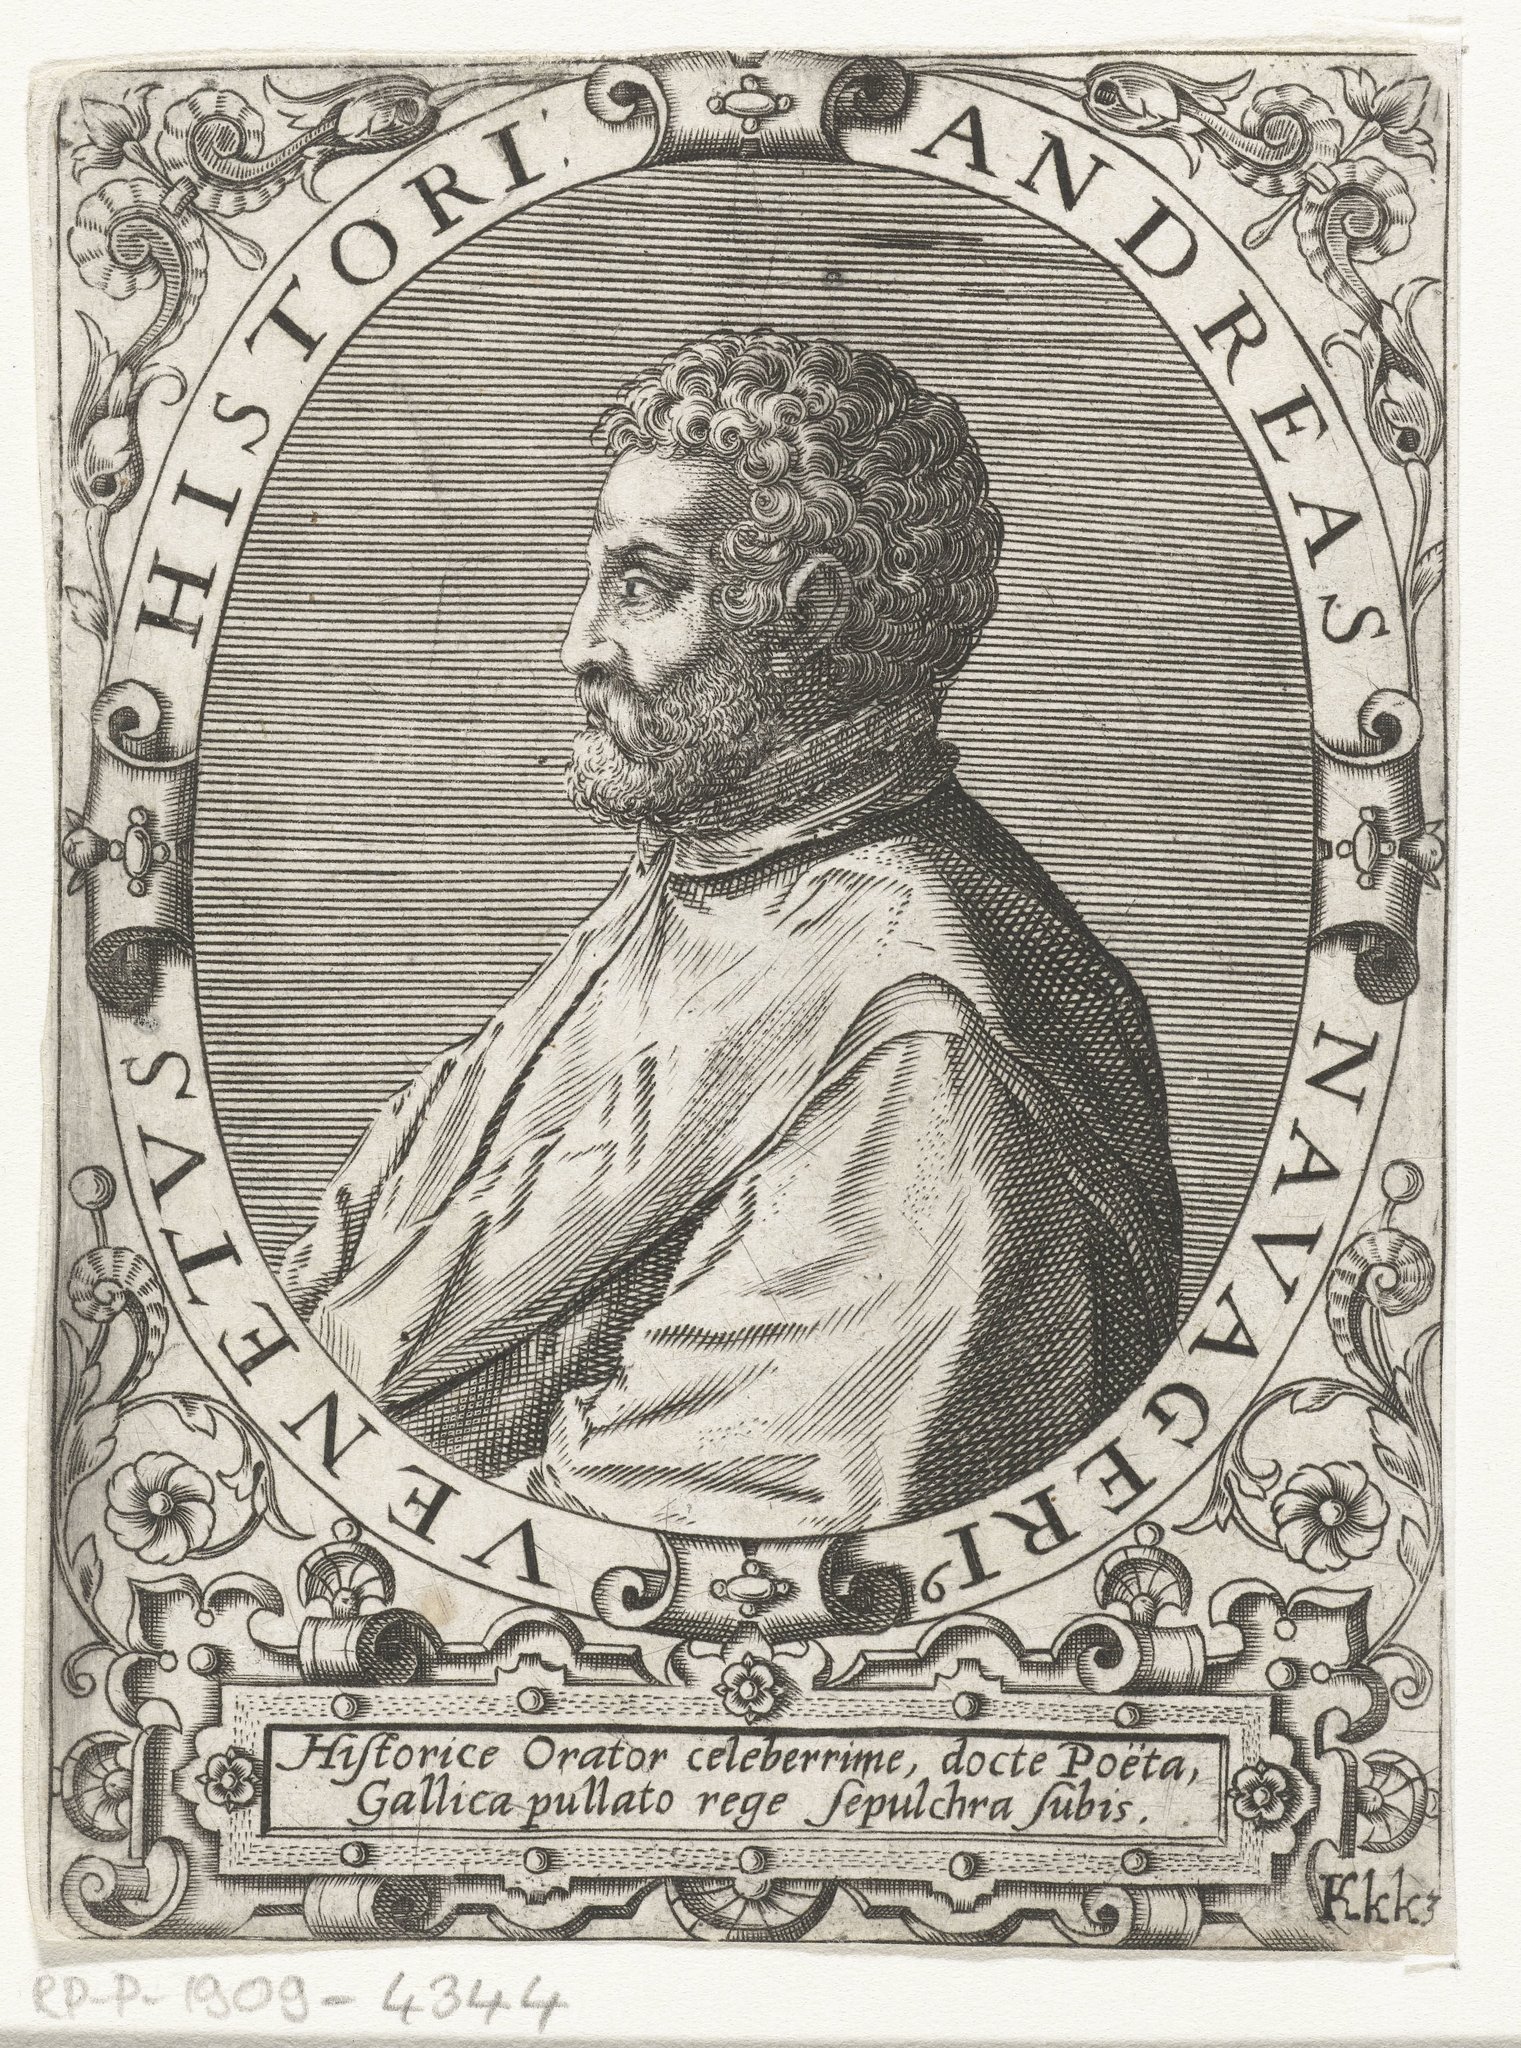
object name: book illustration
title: Andreas Navagerius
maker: jean jacques boissard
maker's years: 1528-1598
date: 1669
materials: paper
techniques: engraving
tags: venice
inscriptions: collector's mark: Lugt 2228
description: Gemaakt voor: J.J. Boissard, Icones virorum illustrium doctrina &c eruditione praestanti um contines. Frankfurt am Main: de Bry, 1597-1599. Opnieuw gebruikt in: J.J.Boissard, Bibliotheca chalcographica, hoc est Virtute et eruditione clarorum Virorum Imagines. Heidelberg: Clemens Ammon, 1669. Dl. 1-5 (te herkennen aan de toegevoegde signatuur in de rechter onderhoek: 3K3).